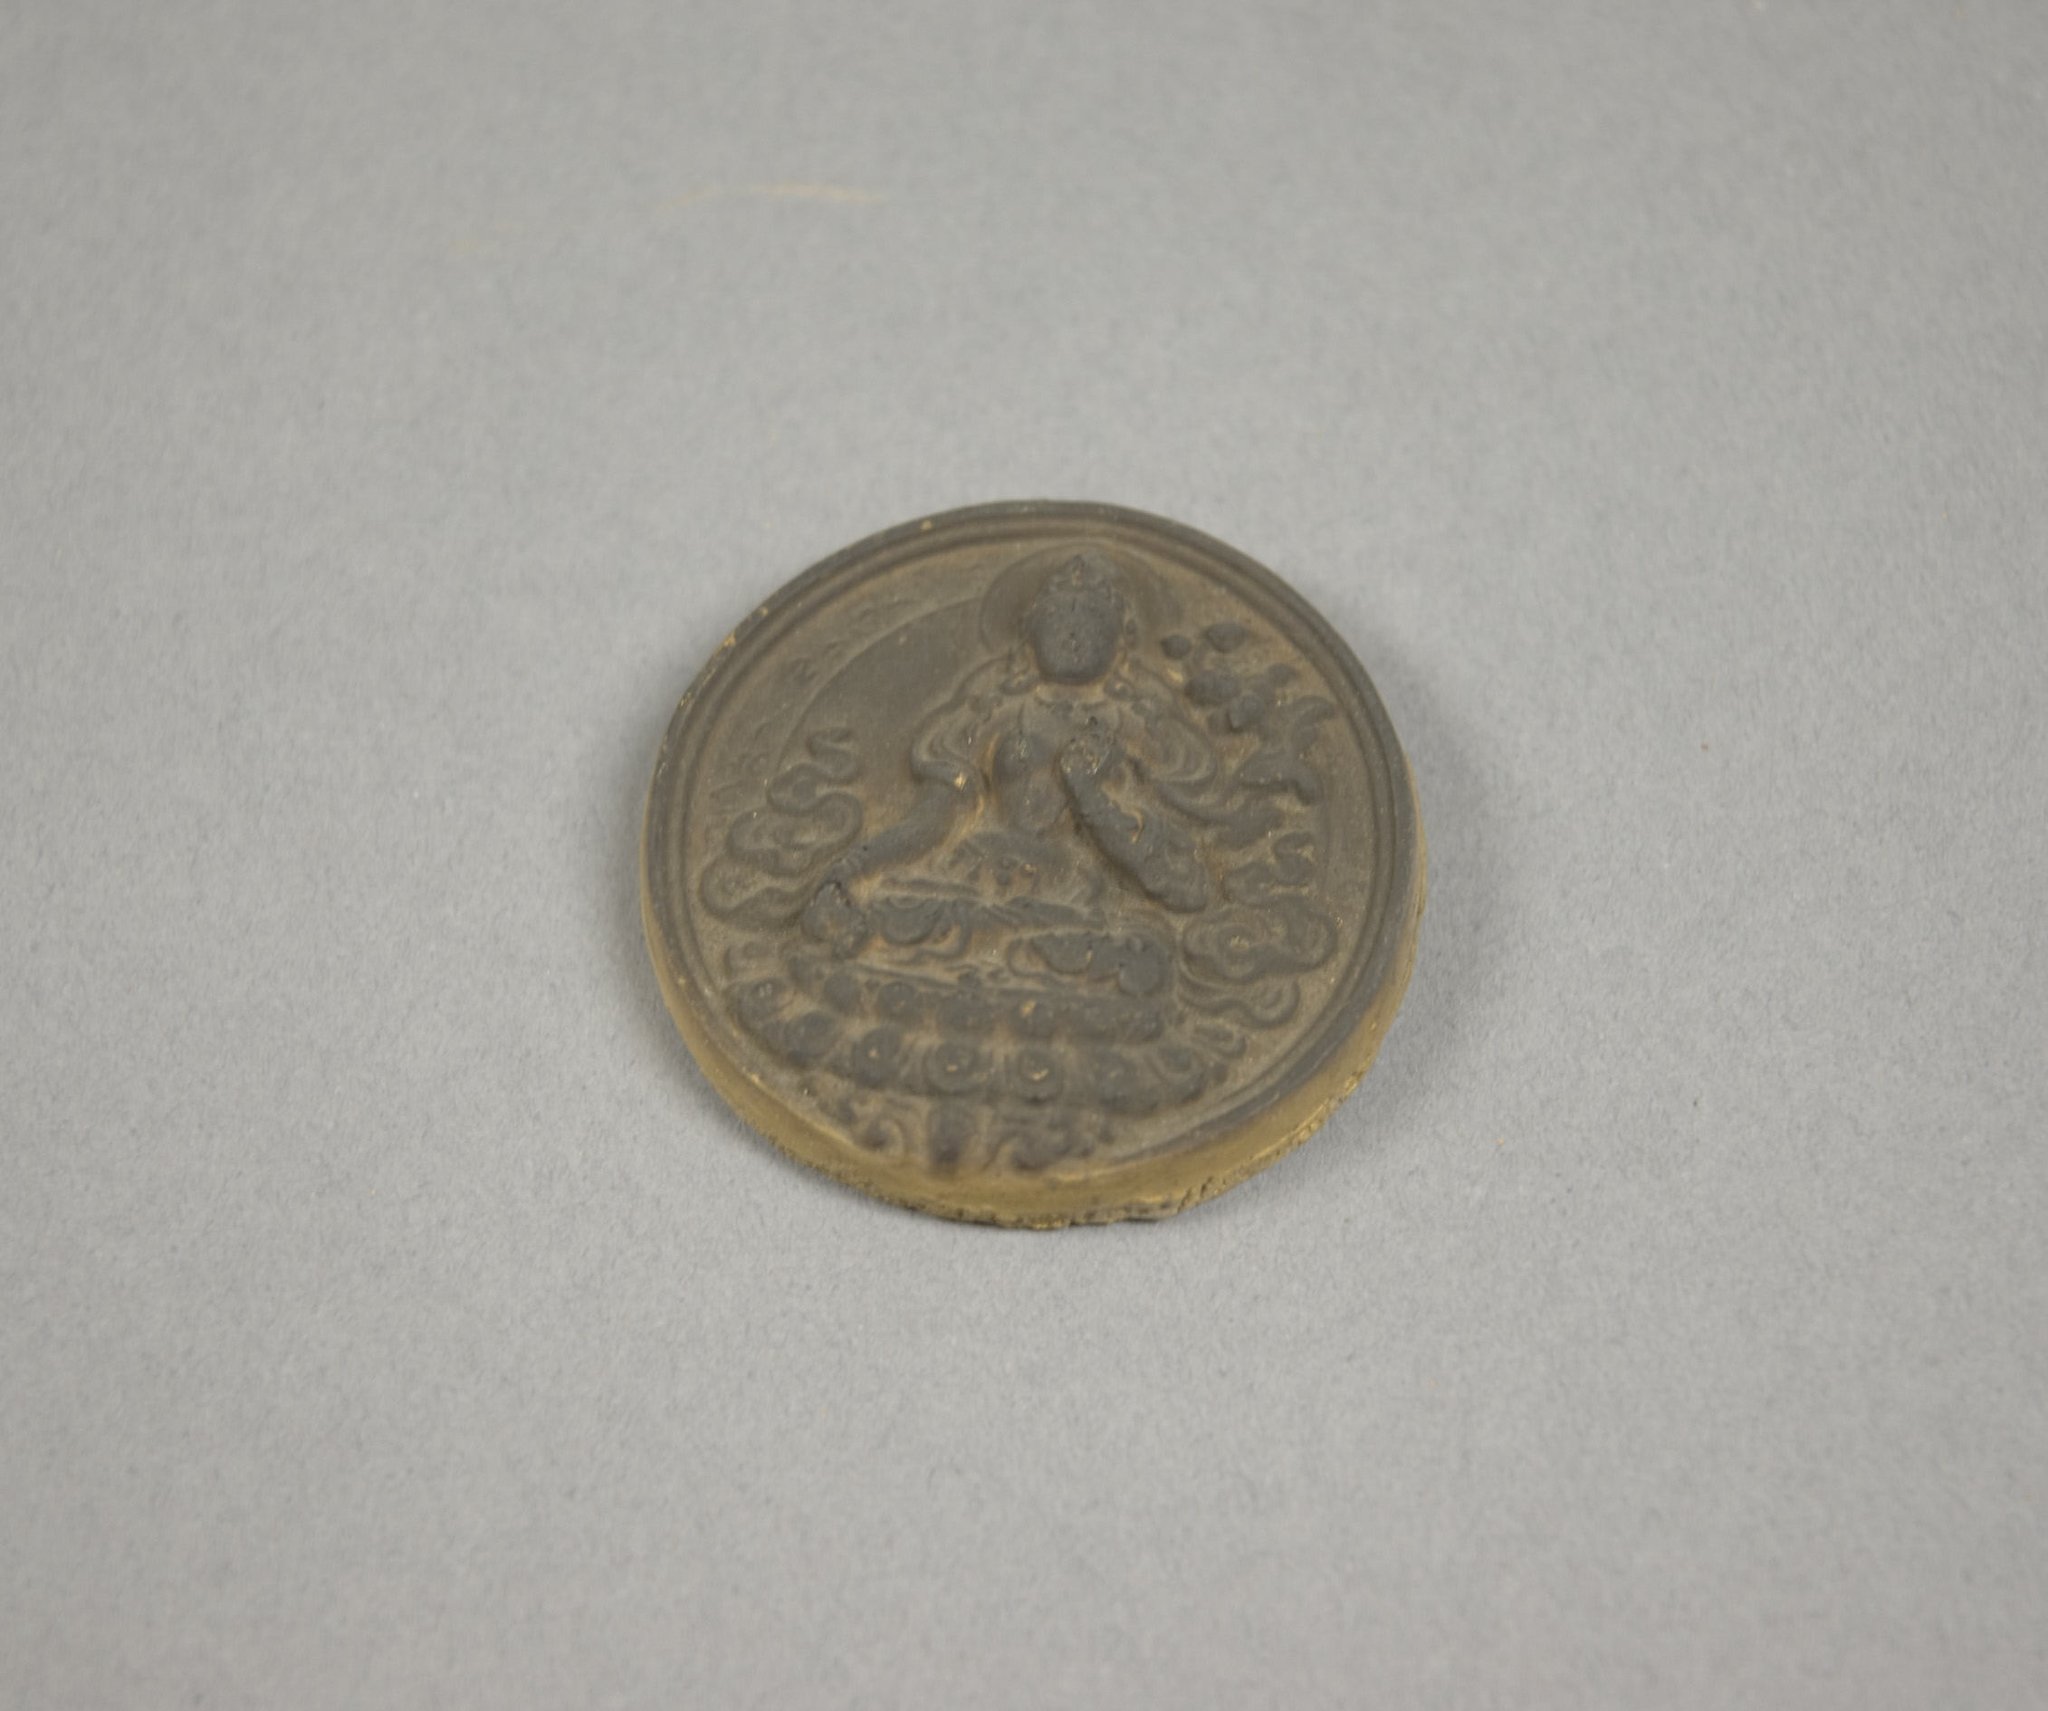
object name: plaque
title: Votive Plaques with White Taras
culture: tibetan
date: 1368-1643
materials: clay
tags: buddhism,deities